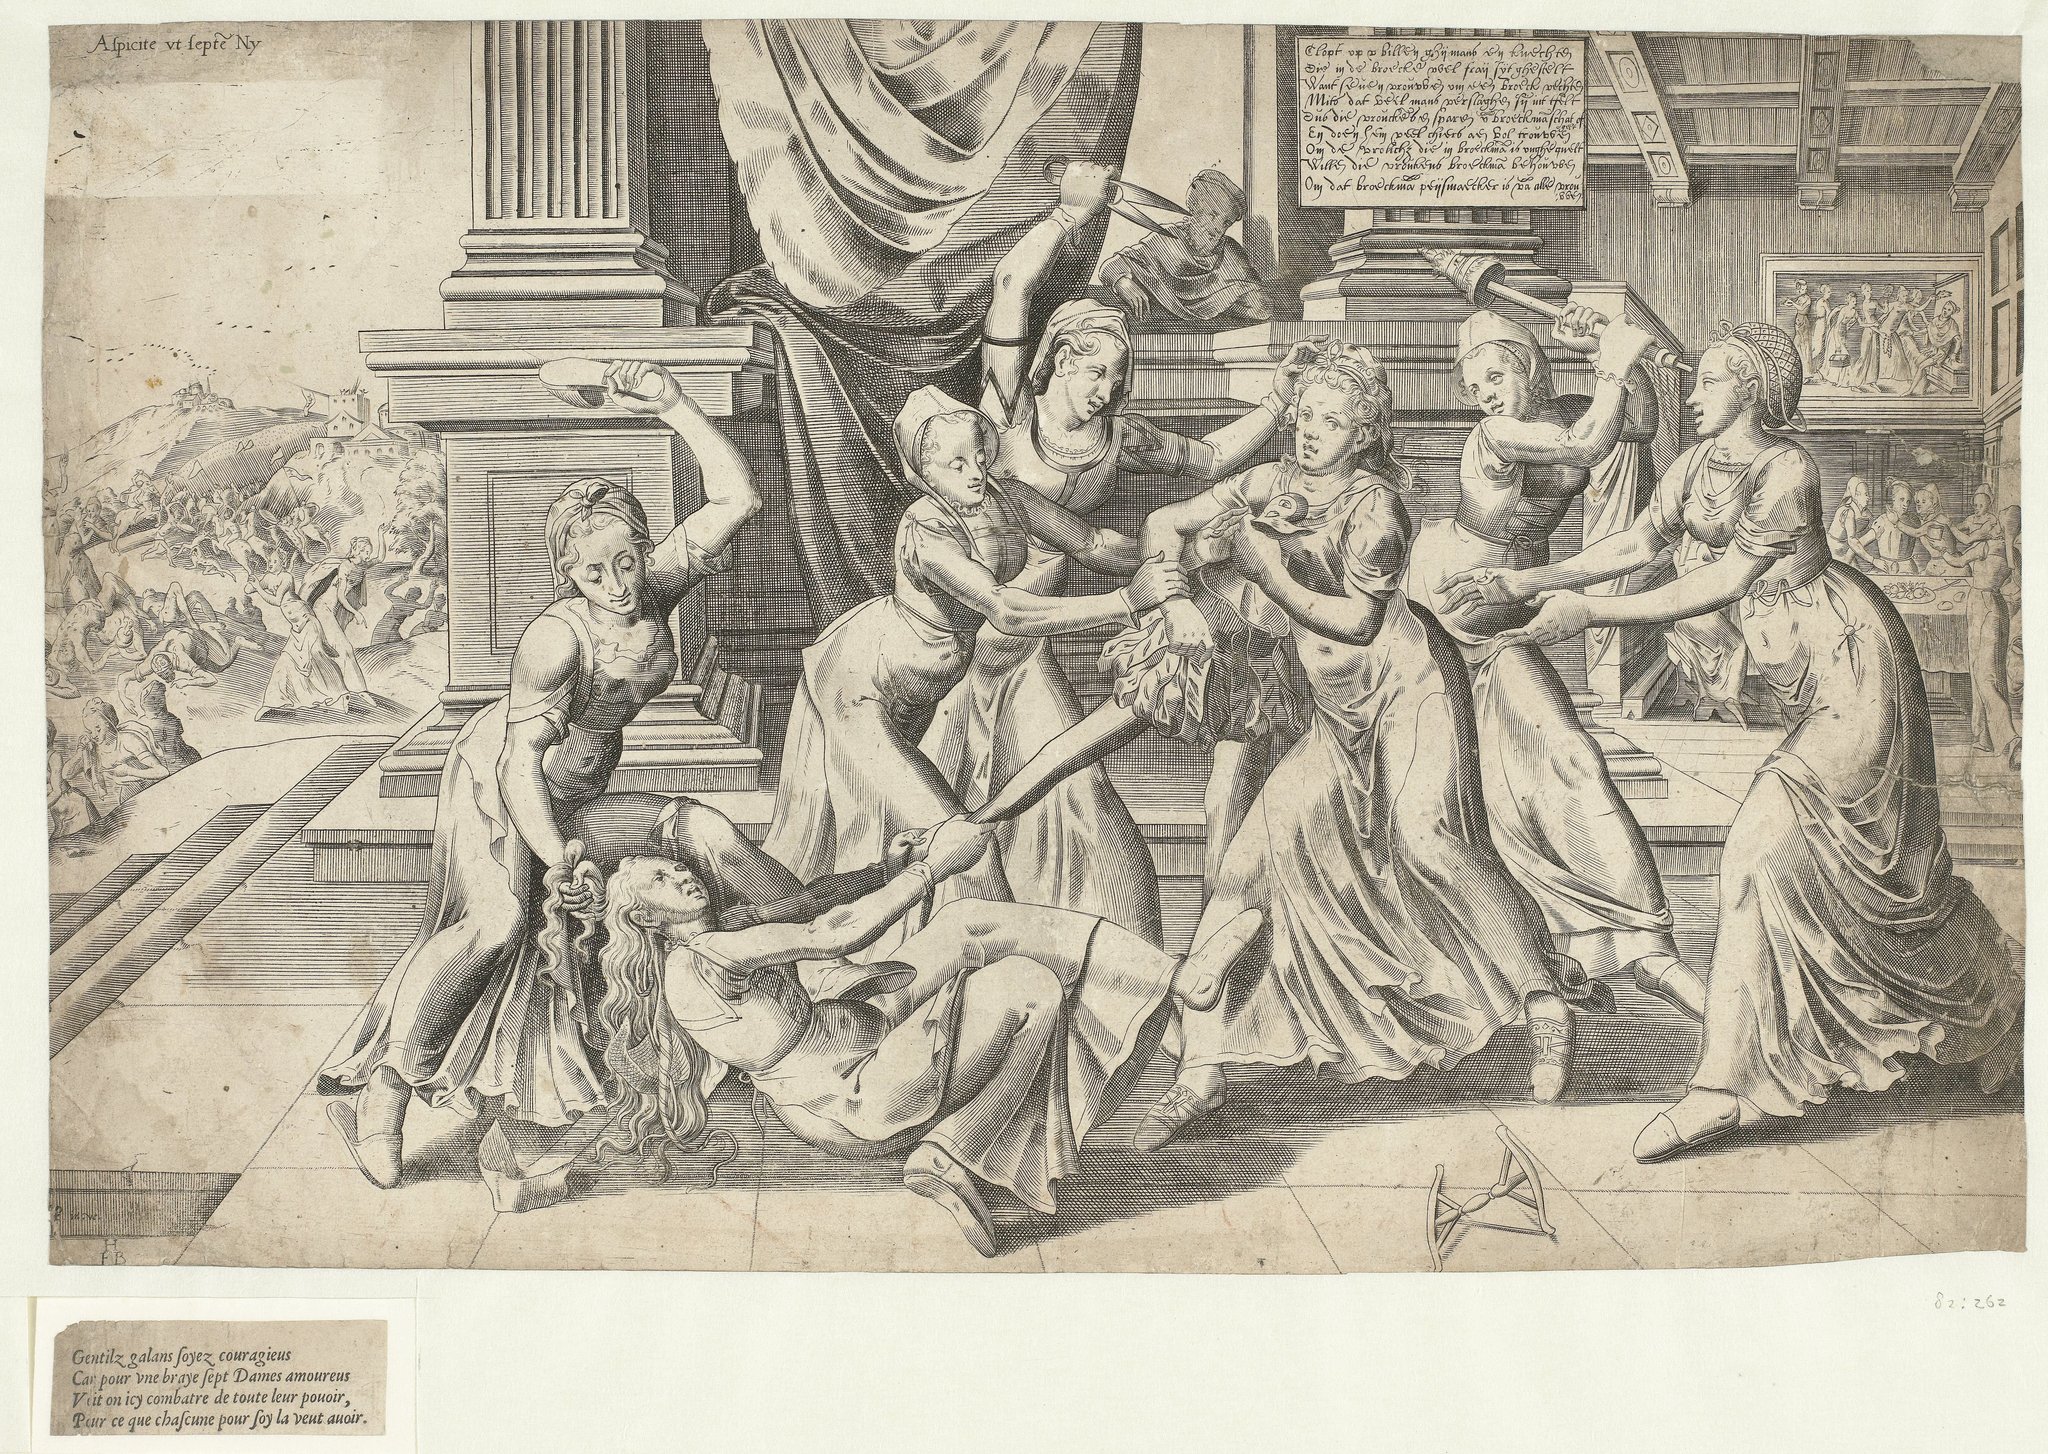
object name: print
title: Strijd om de broek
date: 1540-1590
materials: paper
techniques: engraving, etching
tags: battle for dominance in marriage ('who wears the breeches'), rivalry of women for the love of a man; fight for the hose; 'andouille'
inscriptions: collector's mark: Lugt 2760, collector's mark: Lugt 2228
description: Zeven vrouwen vechten om een mannenbroek. Zij trekken elkaar aan de haren en slaan elkaar met een muil, schaar of spinrokken. Achter een zuil kijkt een man toe. Rechts achter een gezelschap van één man en enkele vrouwen aan een gedekte tafel. De man wordt geliefkoosd. Links op de achtergrond een gevecht tussen soldaten en vrouwen. De tekst rechtsboven verklaart dat de afbeelding de rivaliteit tussen vrouwen om de liefde van een man verbeeldt. Linksonder op het opzetblad een tekst van vier regels in het Frans op een apart stukje papier.